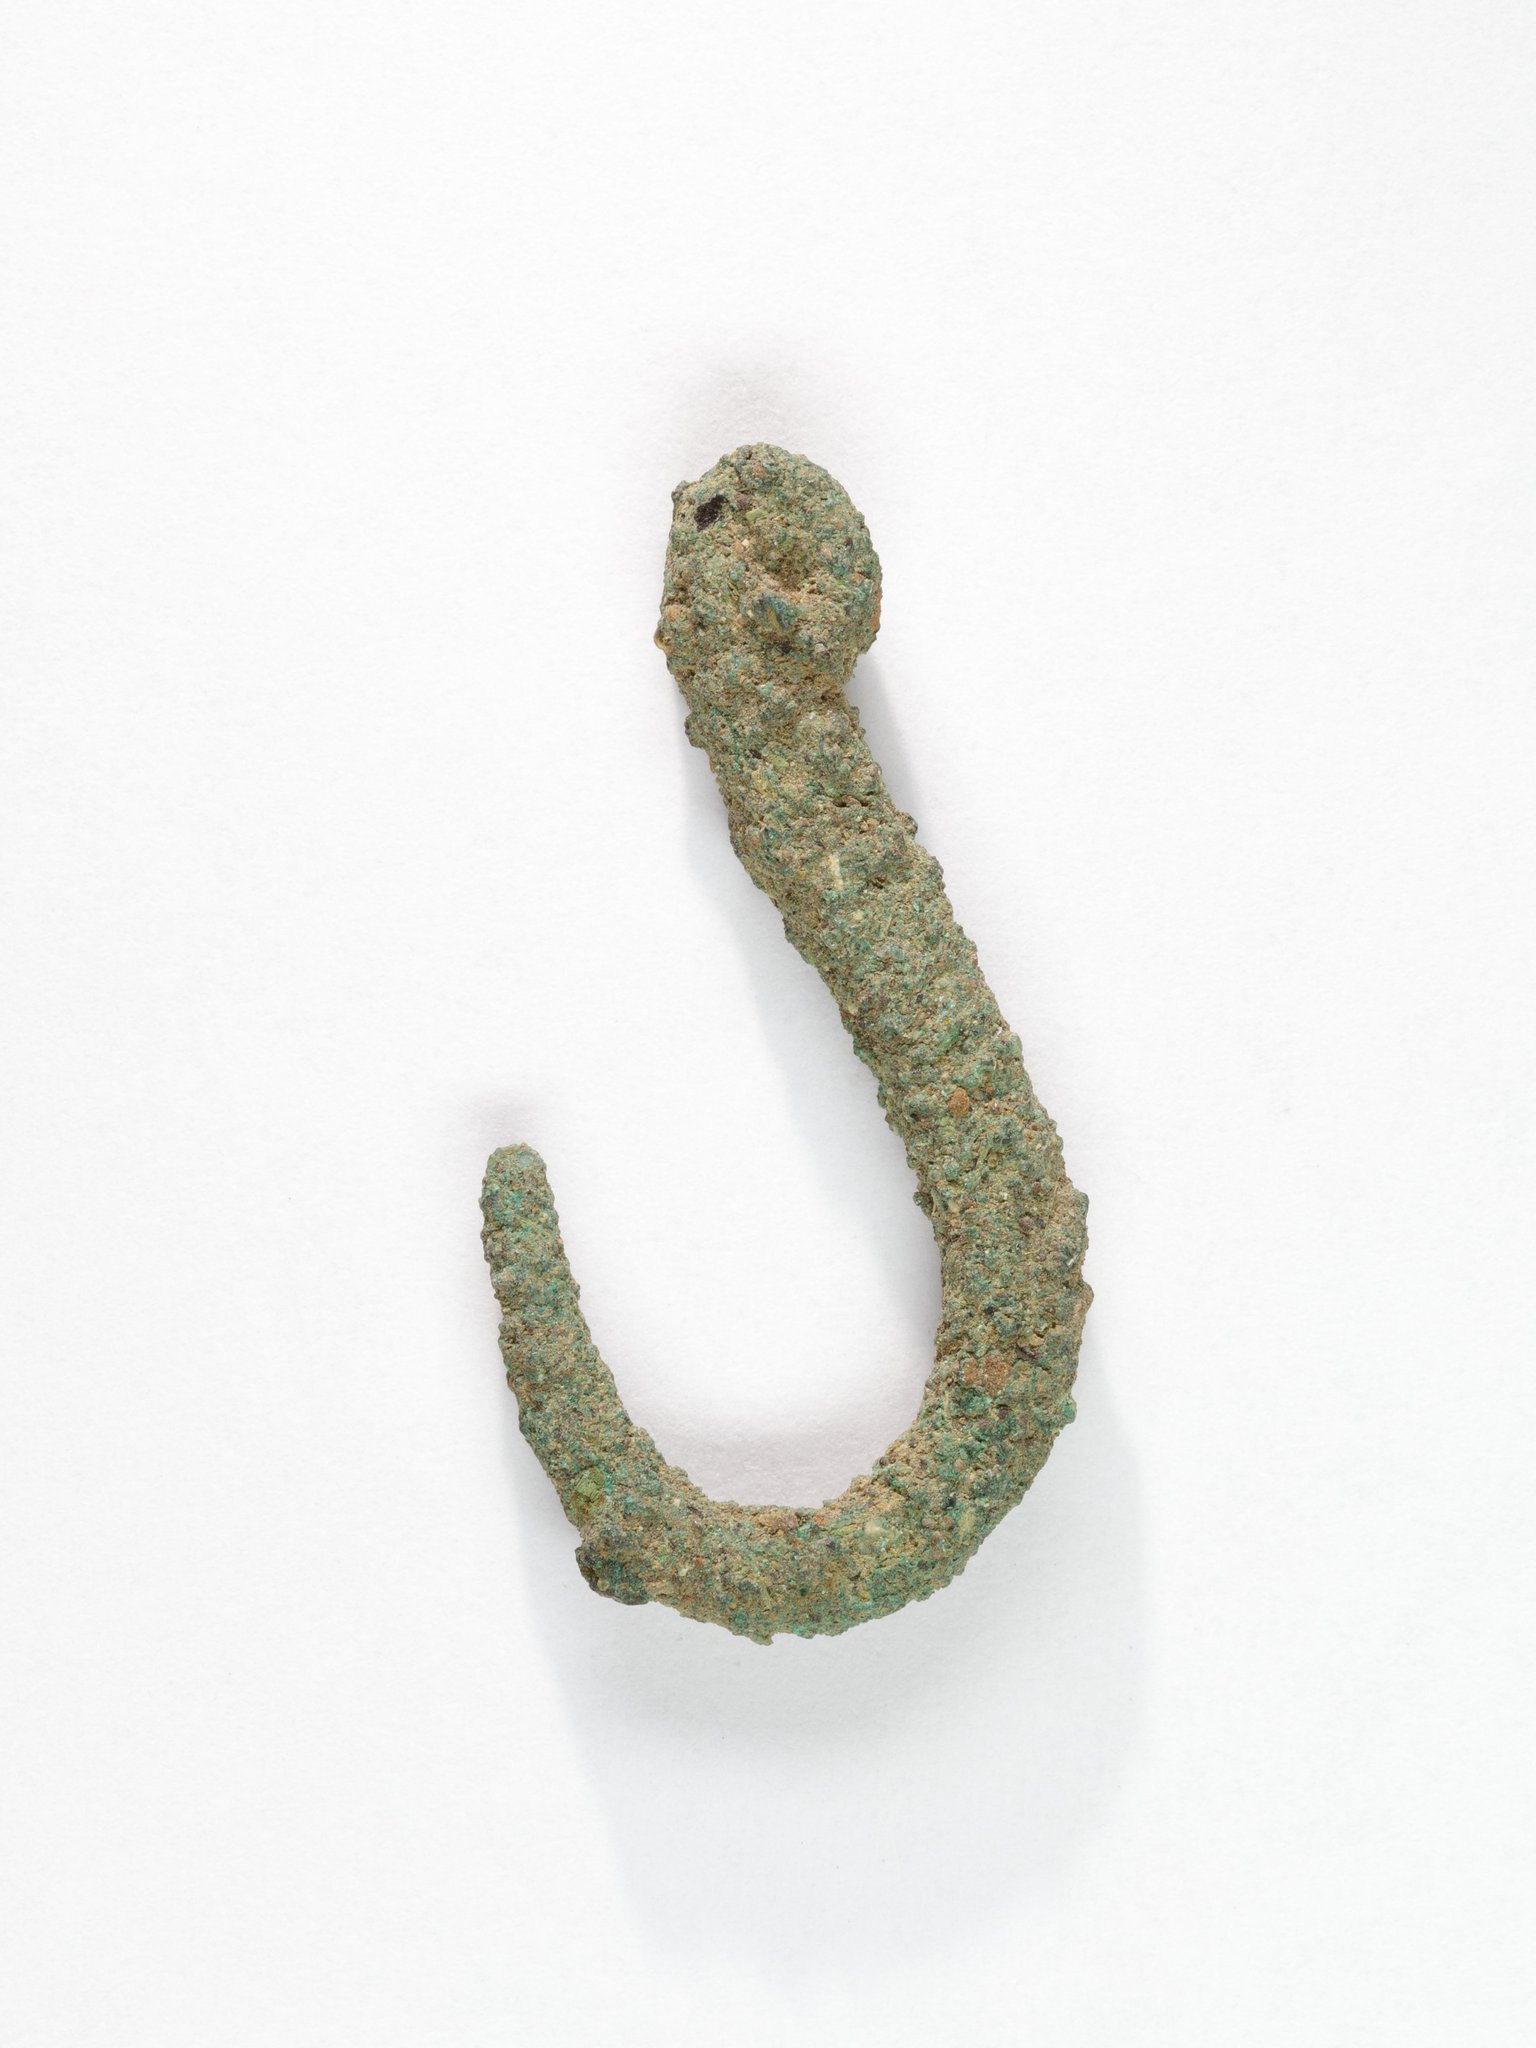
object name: fish hook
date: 1295-1070 BCE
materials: copper alloy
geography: northern upper egypt